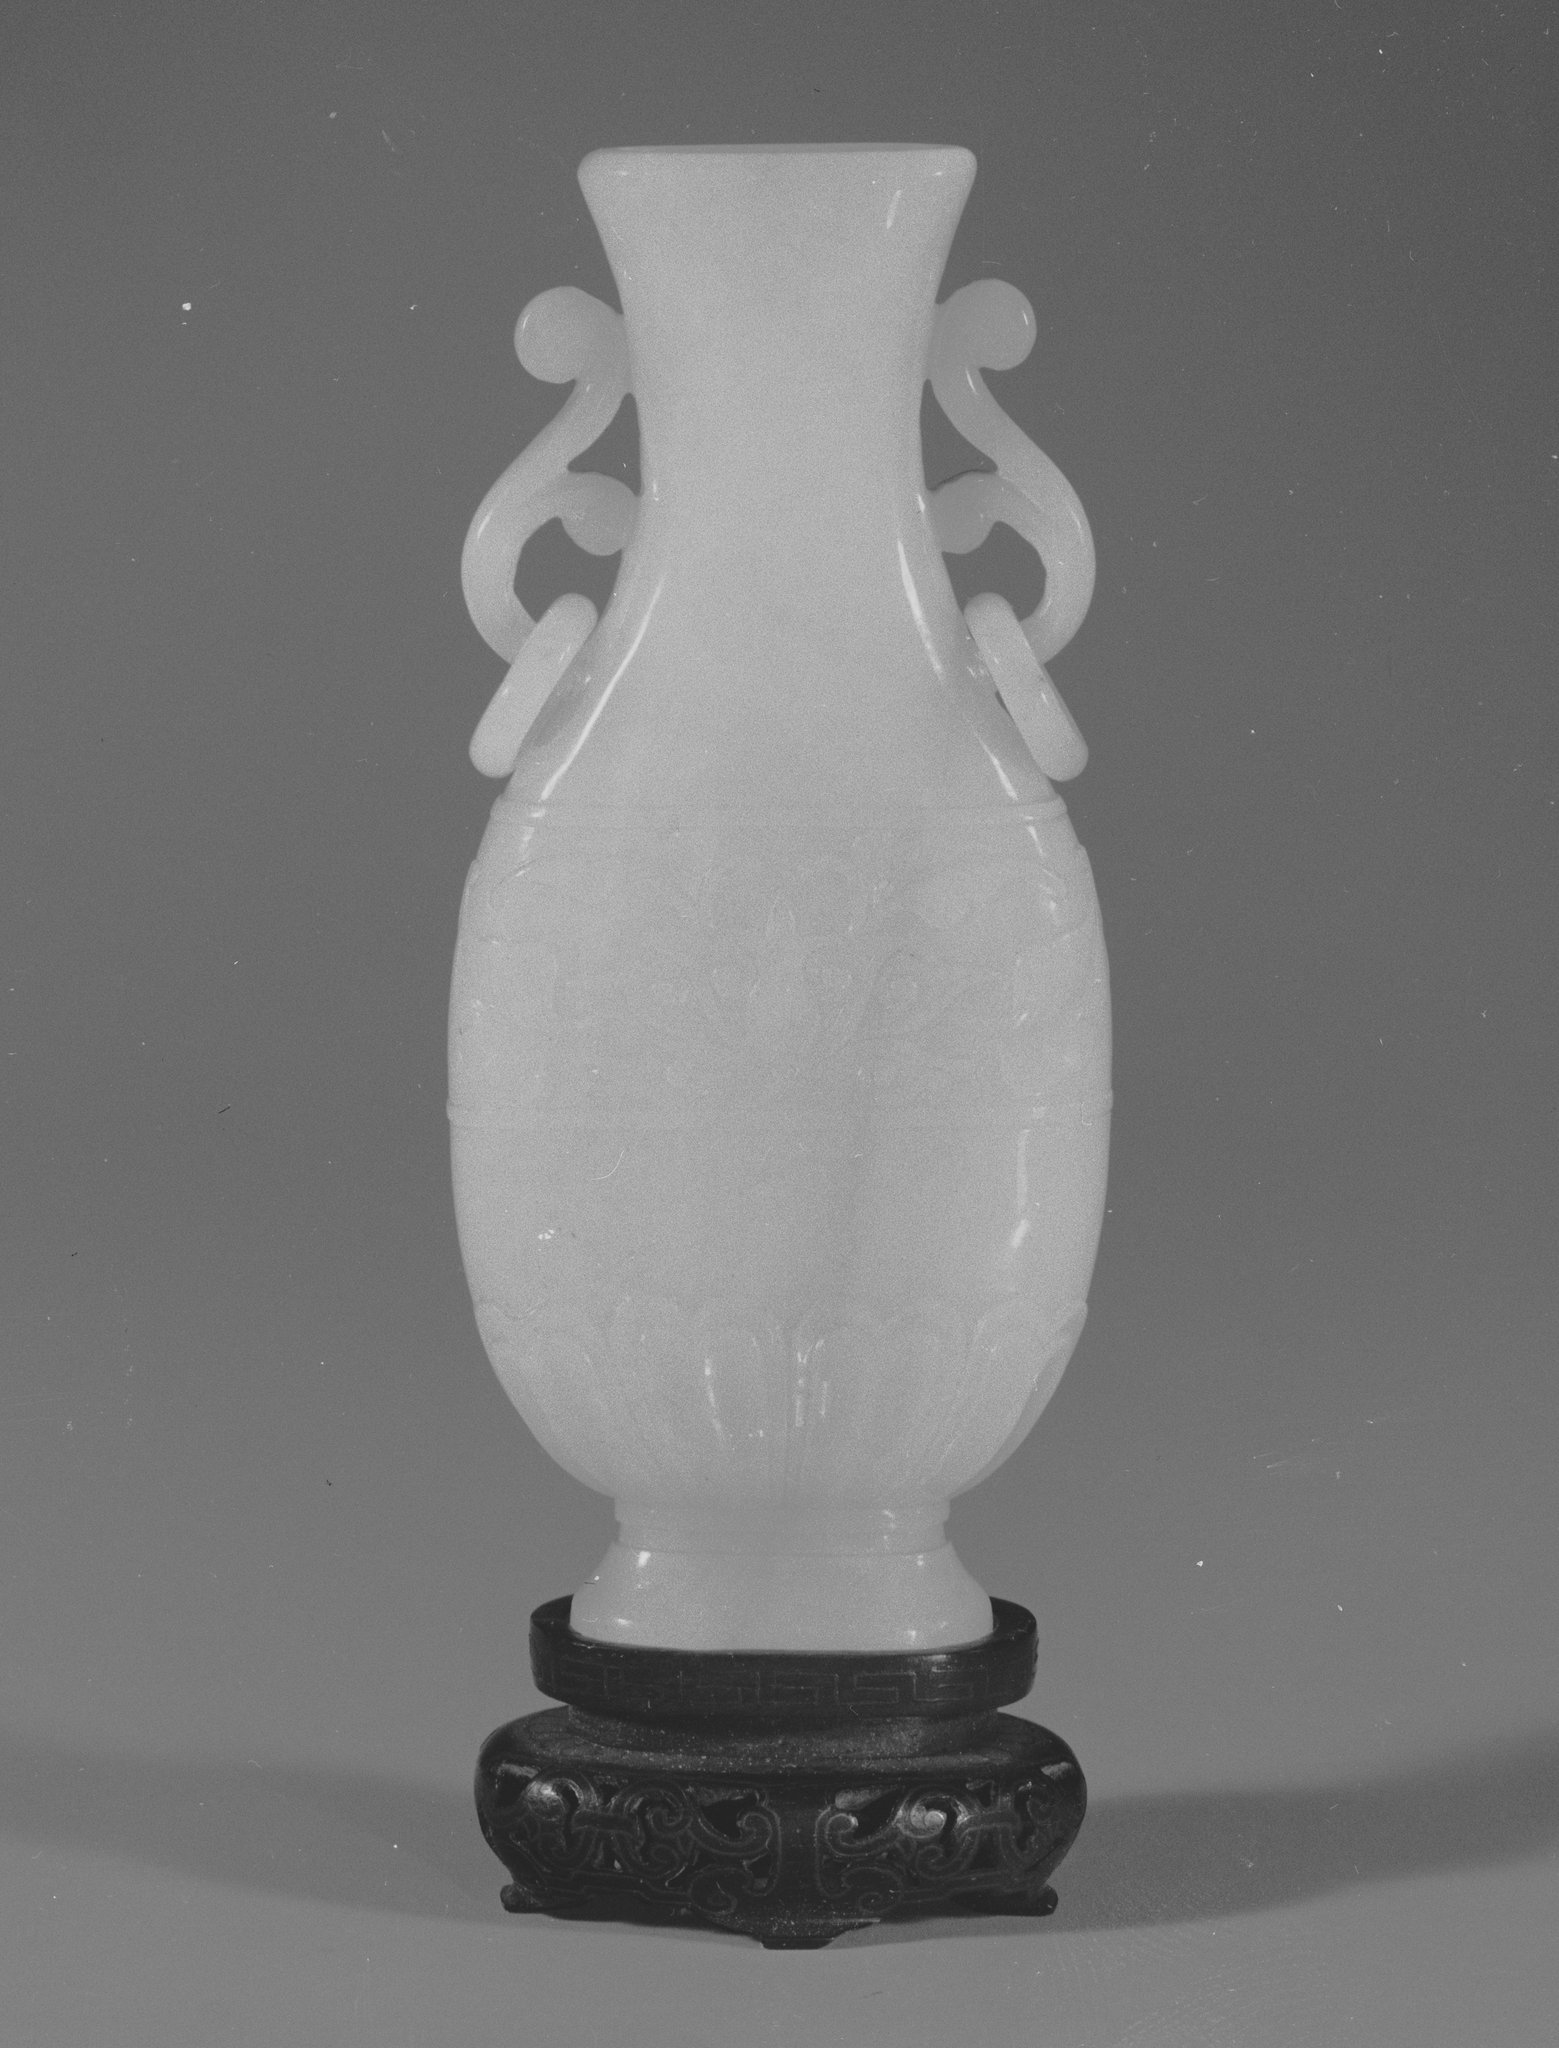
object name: vase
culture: chinese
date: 1767-1800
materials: jade